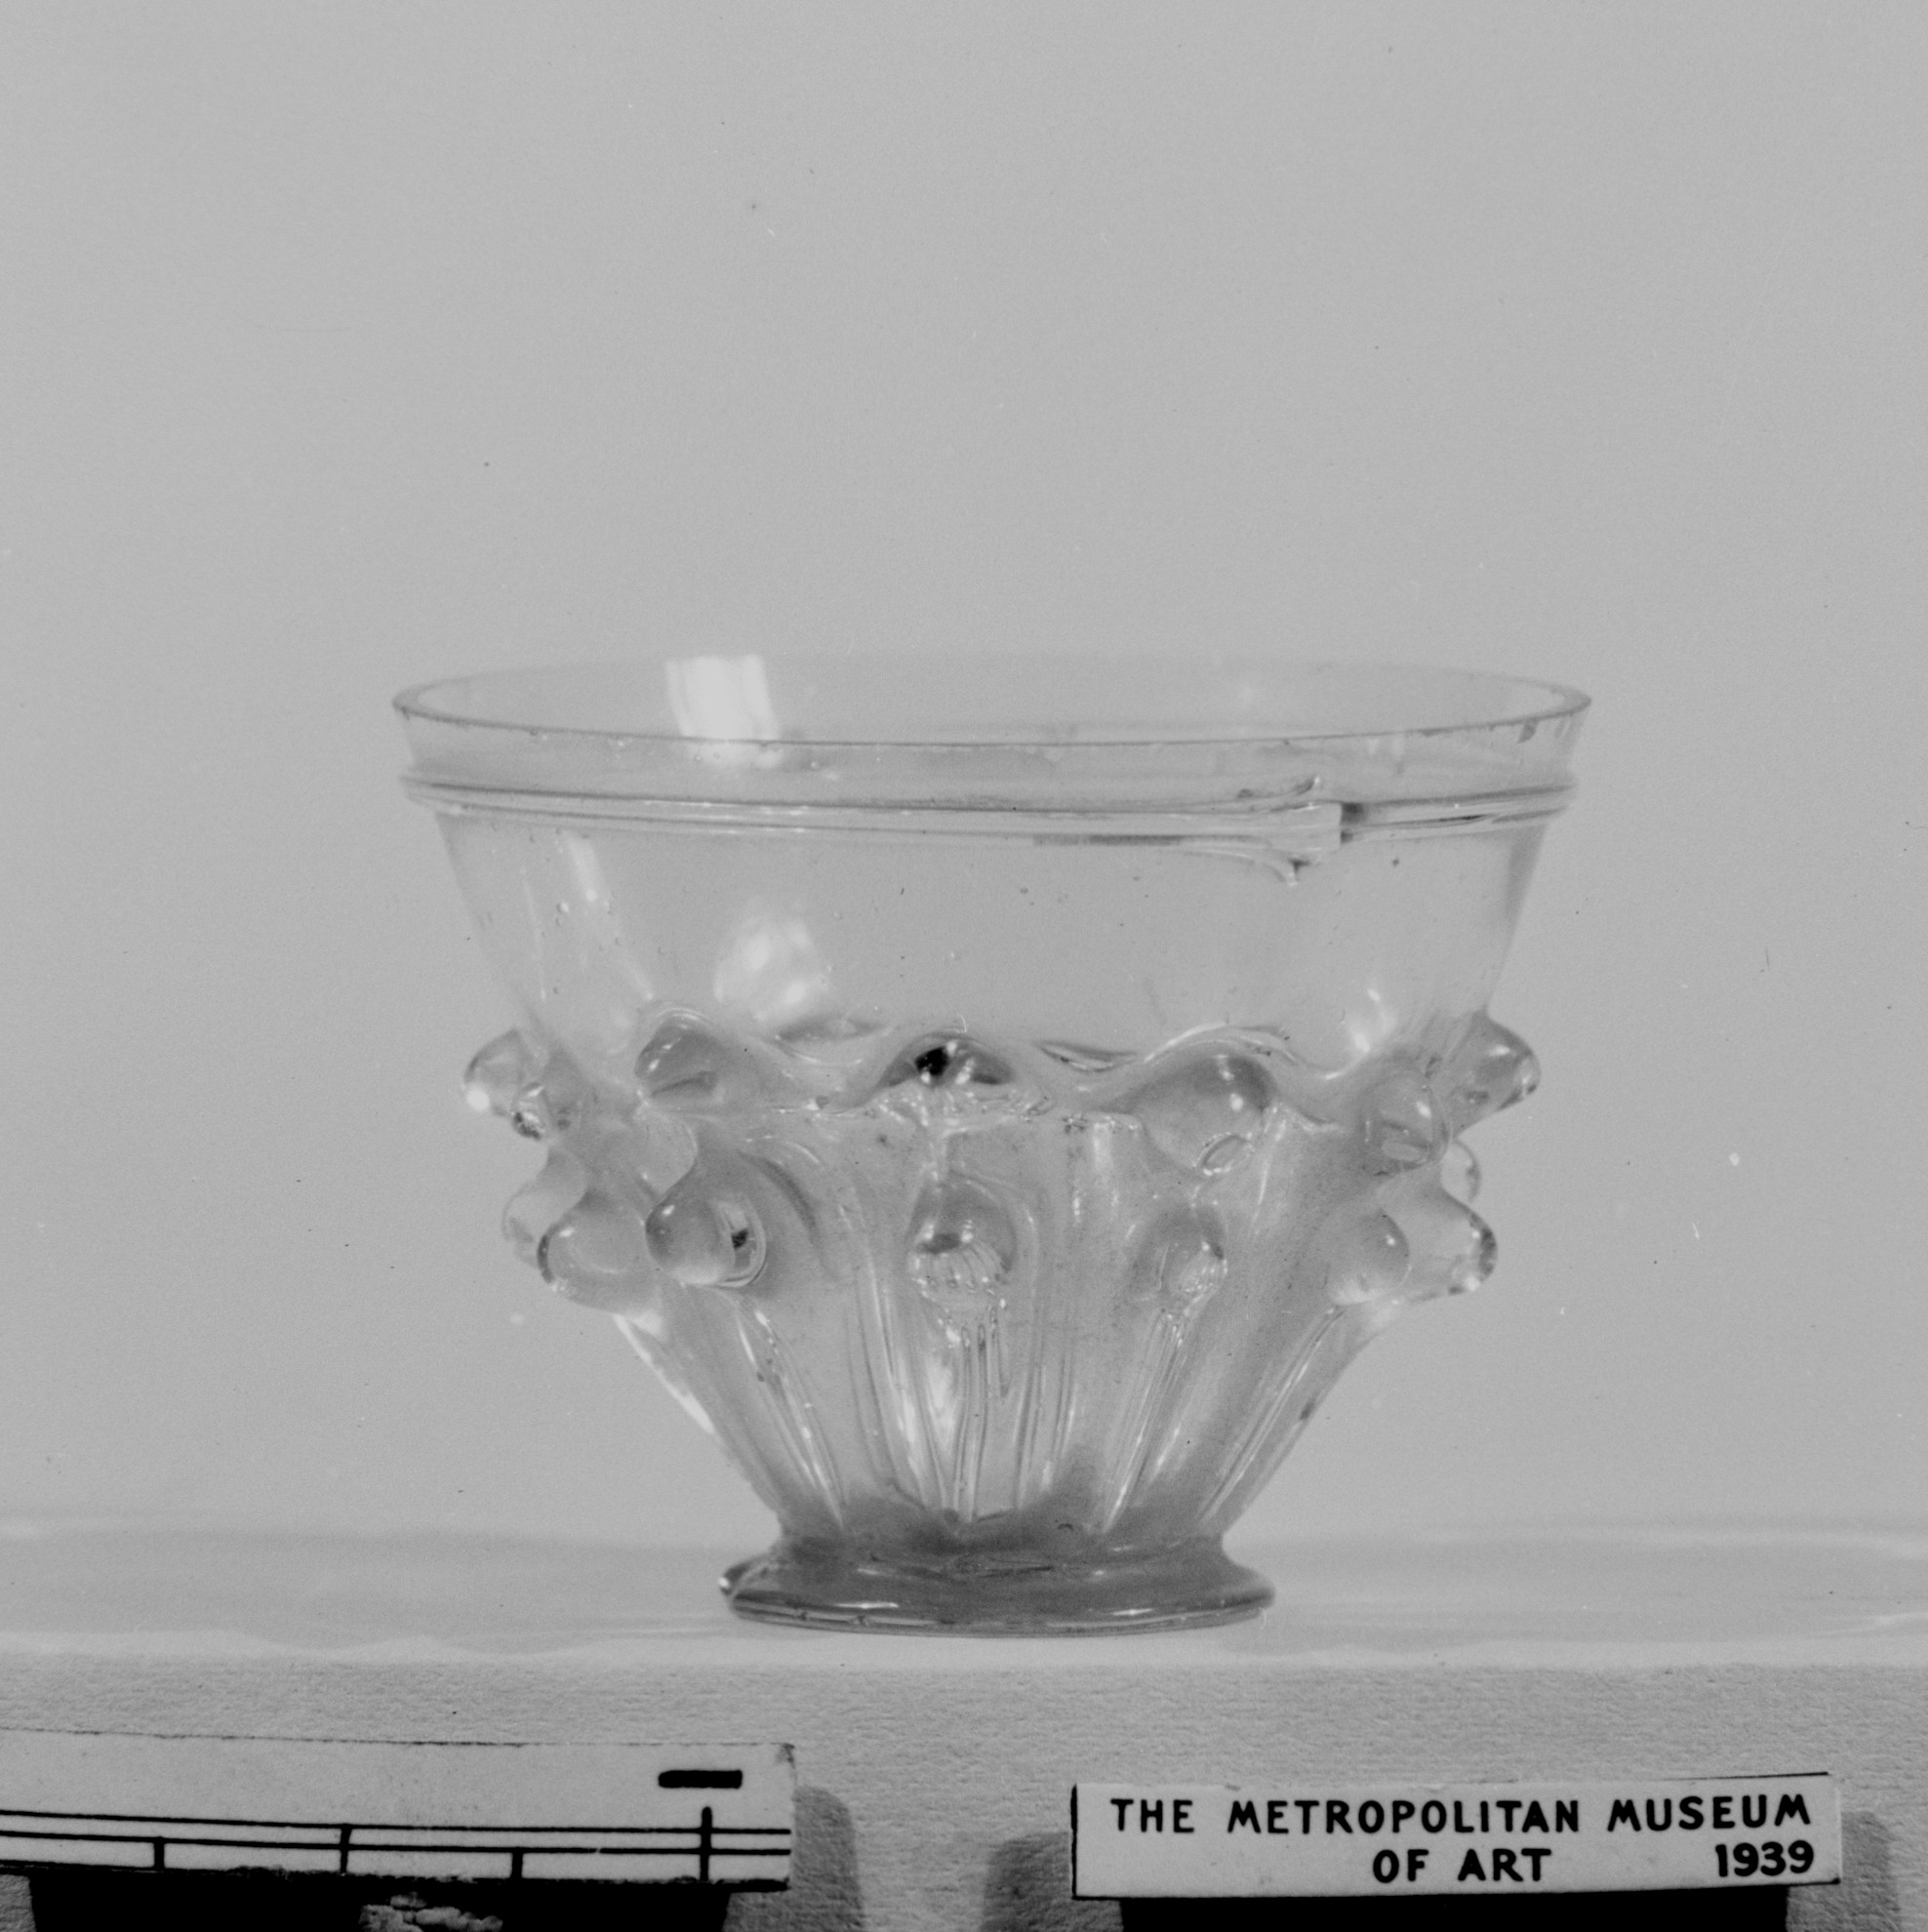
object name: wineglass fragment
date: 1701-1733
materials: glass